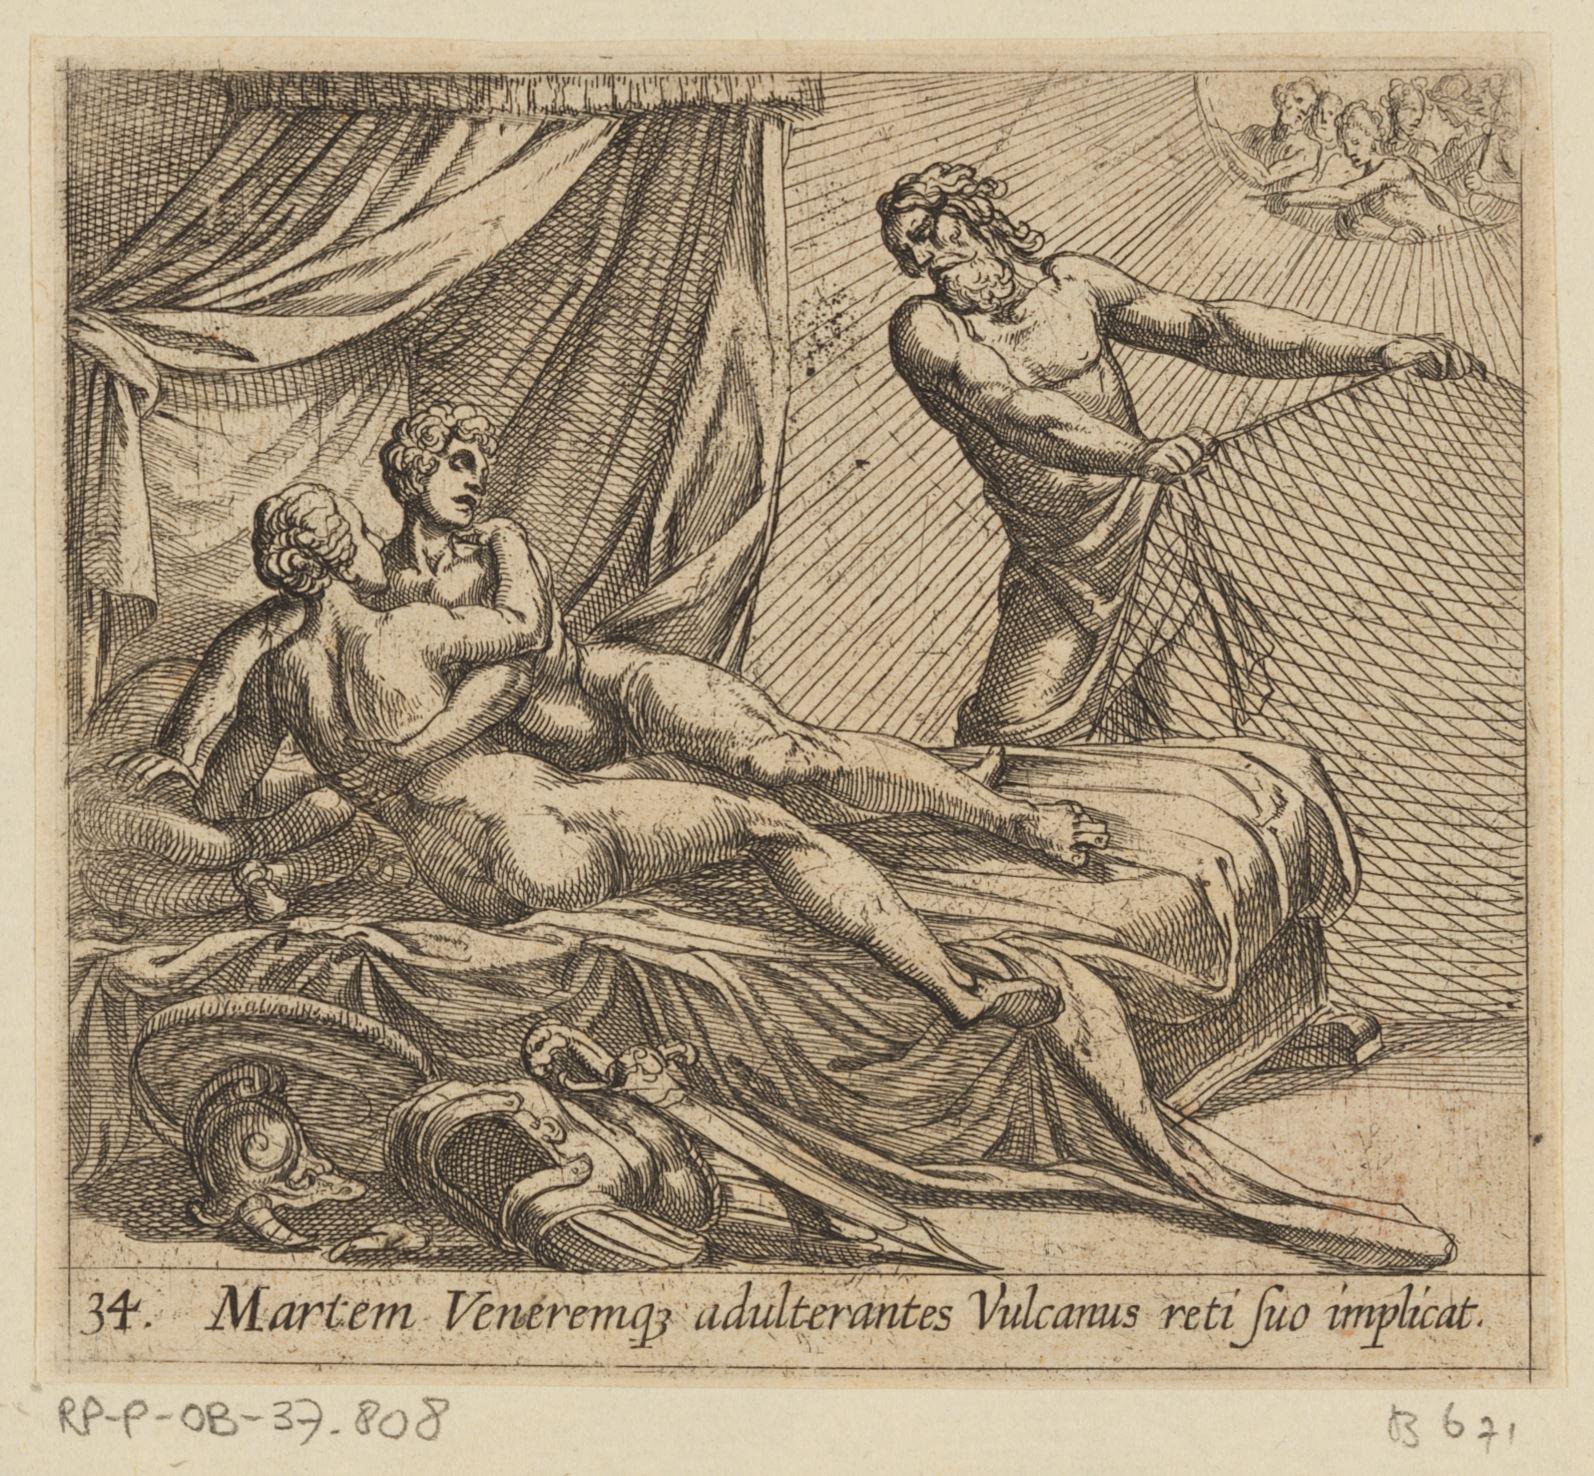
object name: print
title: Martem Veneremqe adulterantes Vulcanus reti suo implicat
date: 1606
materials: paper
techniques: etching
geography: antwerp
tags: mars and venus surprised by vulcan; he catches them in a net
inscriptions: collector's mark: Lugt 240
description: Deze prent maakt deel uit van een reeks van 150 prenten (+ titelprent) met voorstellingen van de Metamorfosen van Ovidius.